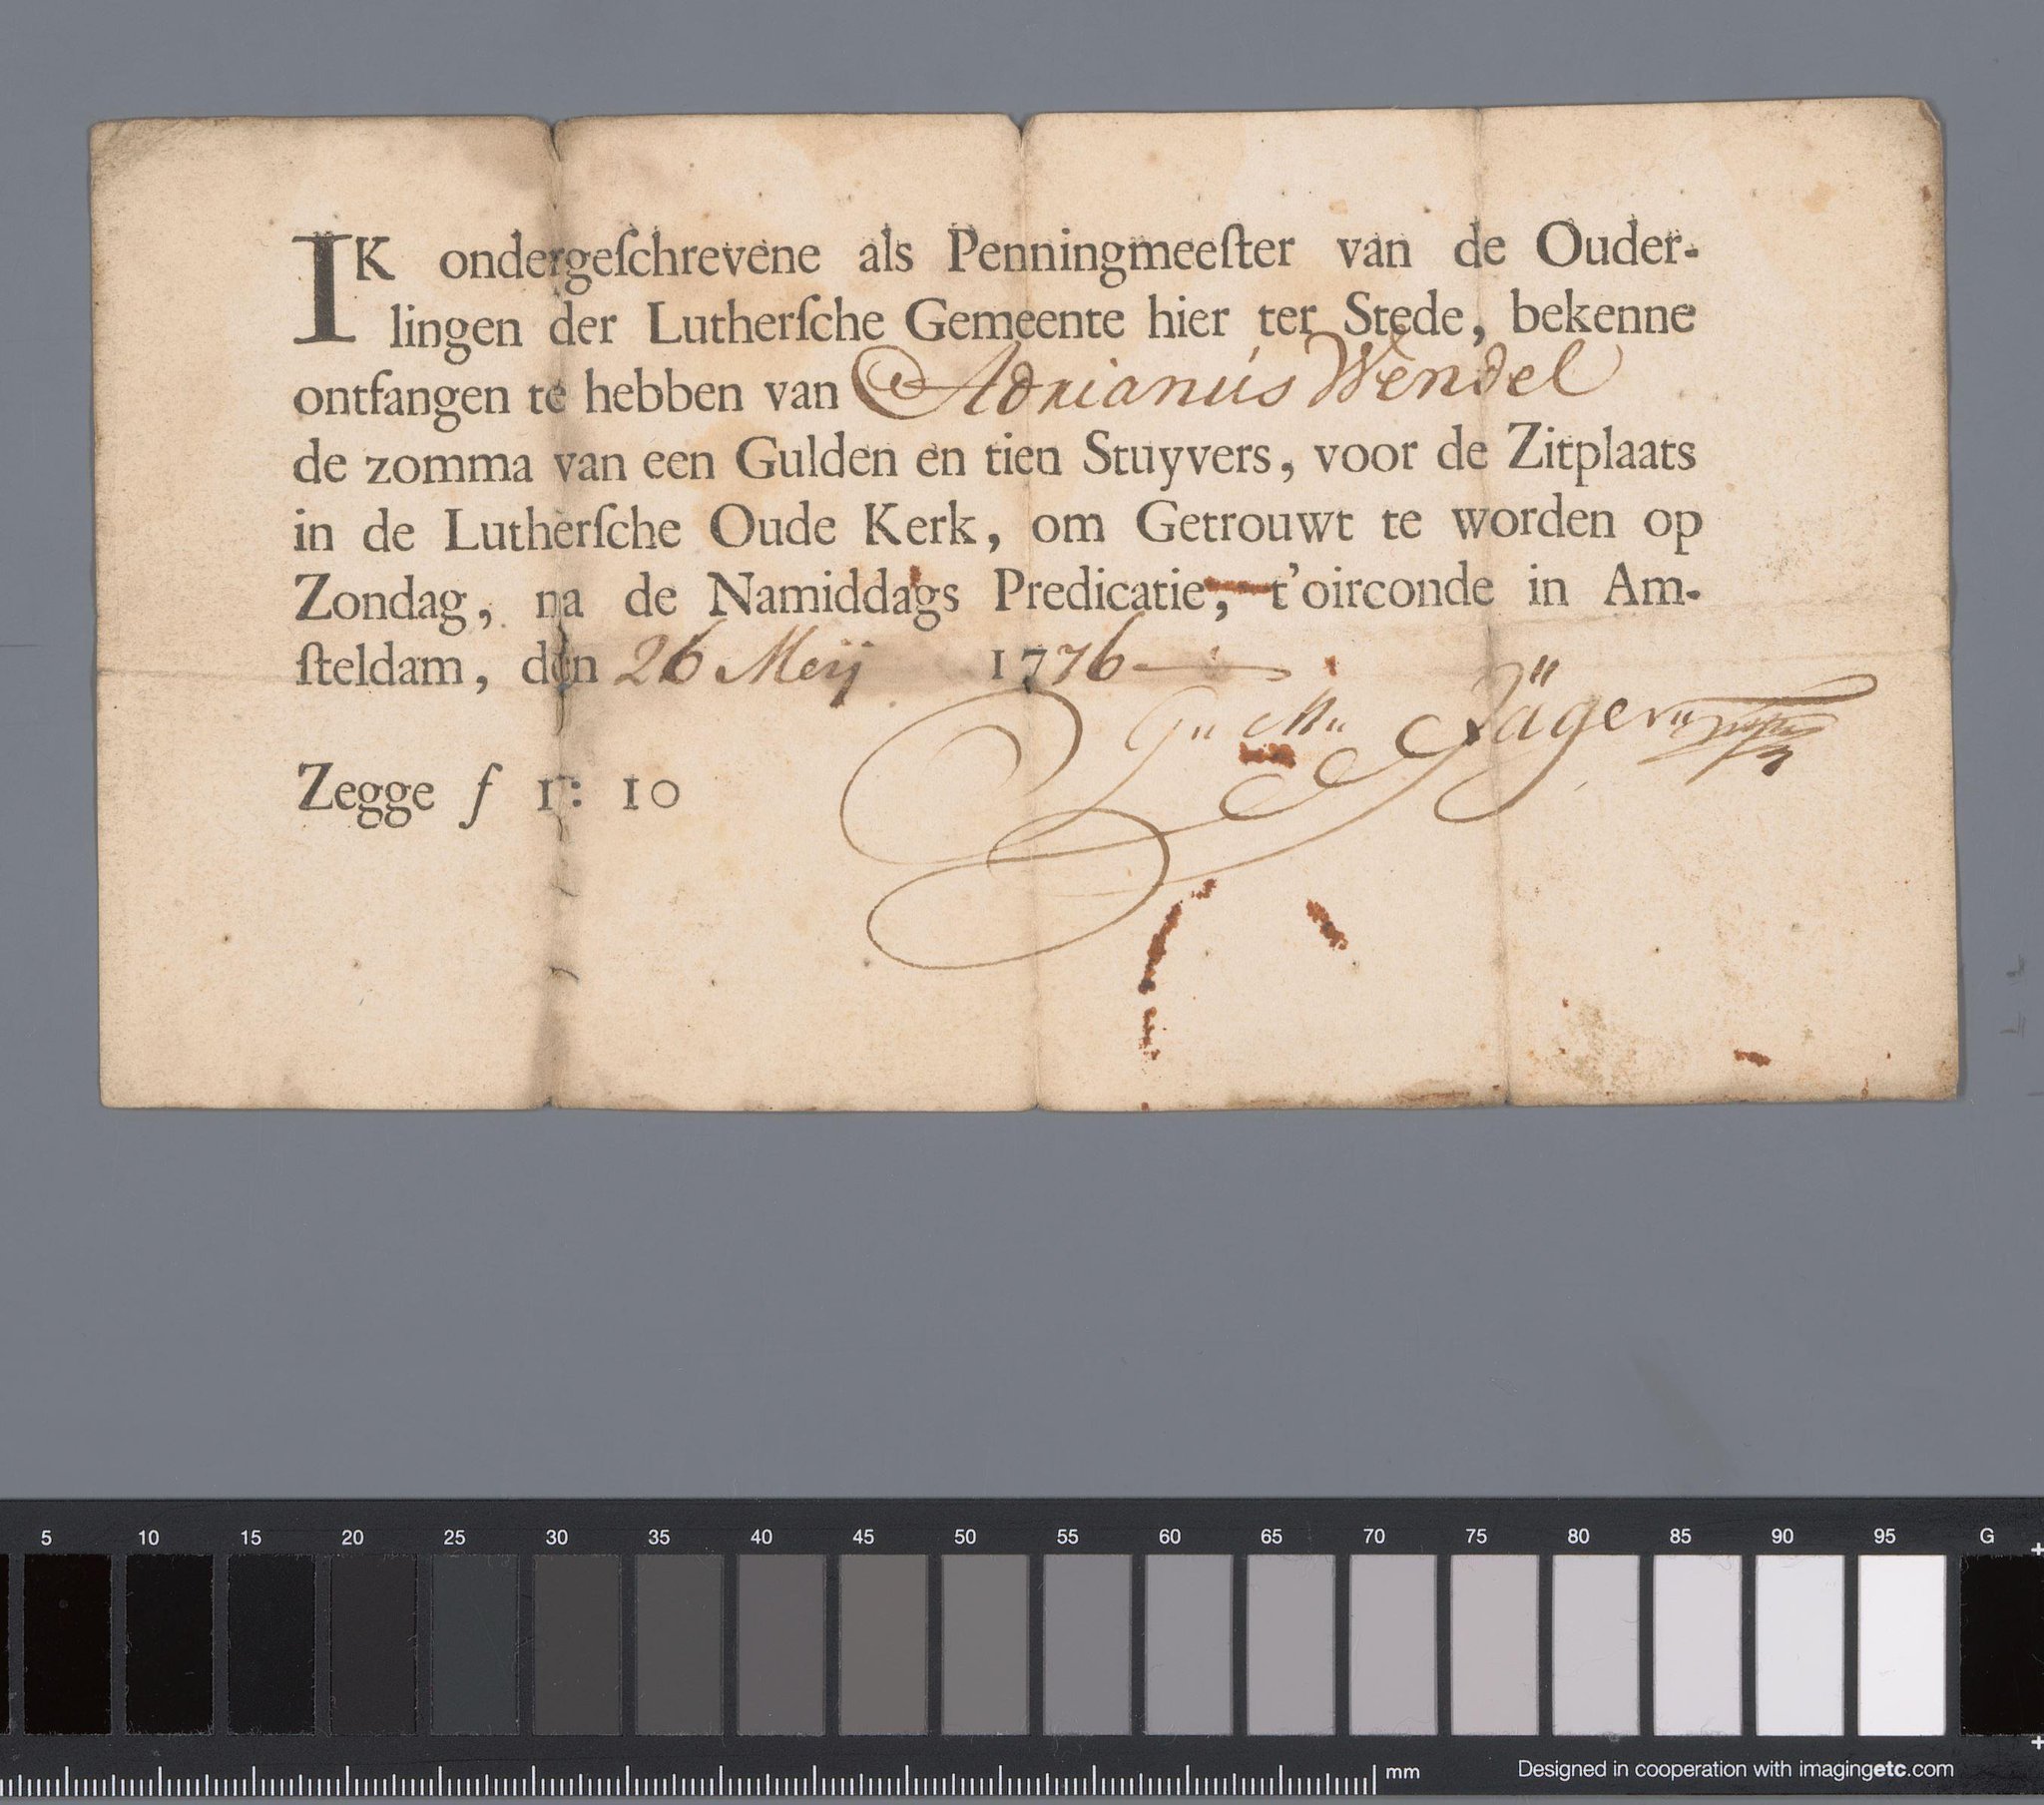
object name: document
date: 1776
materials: paper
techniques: printing, writing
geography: amsterdam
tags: adrianus wendel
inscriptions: date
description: Eénzijdig bedrukt document, bewijs van ontvangst van 1 gulden en 10 stuivers voor het huwelijk van A. Wendel. Gesigneerd en gedateerd.